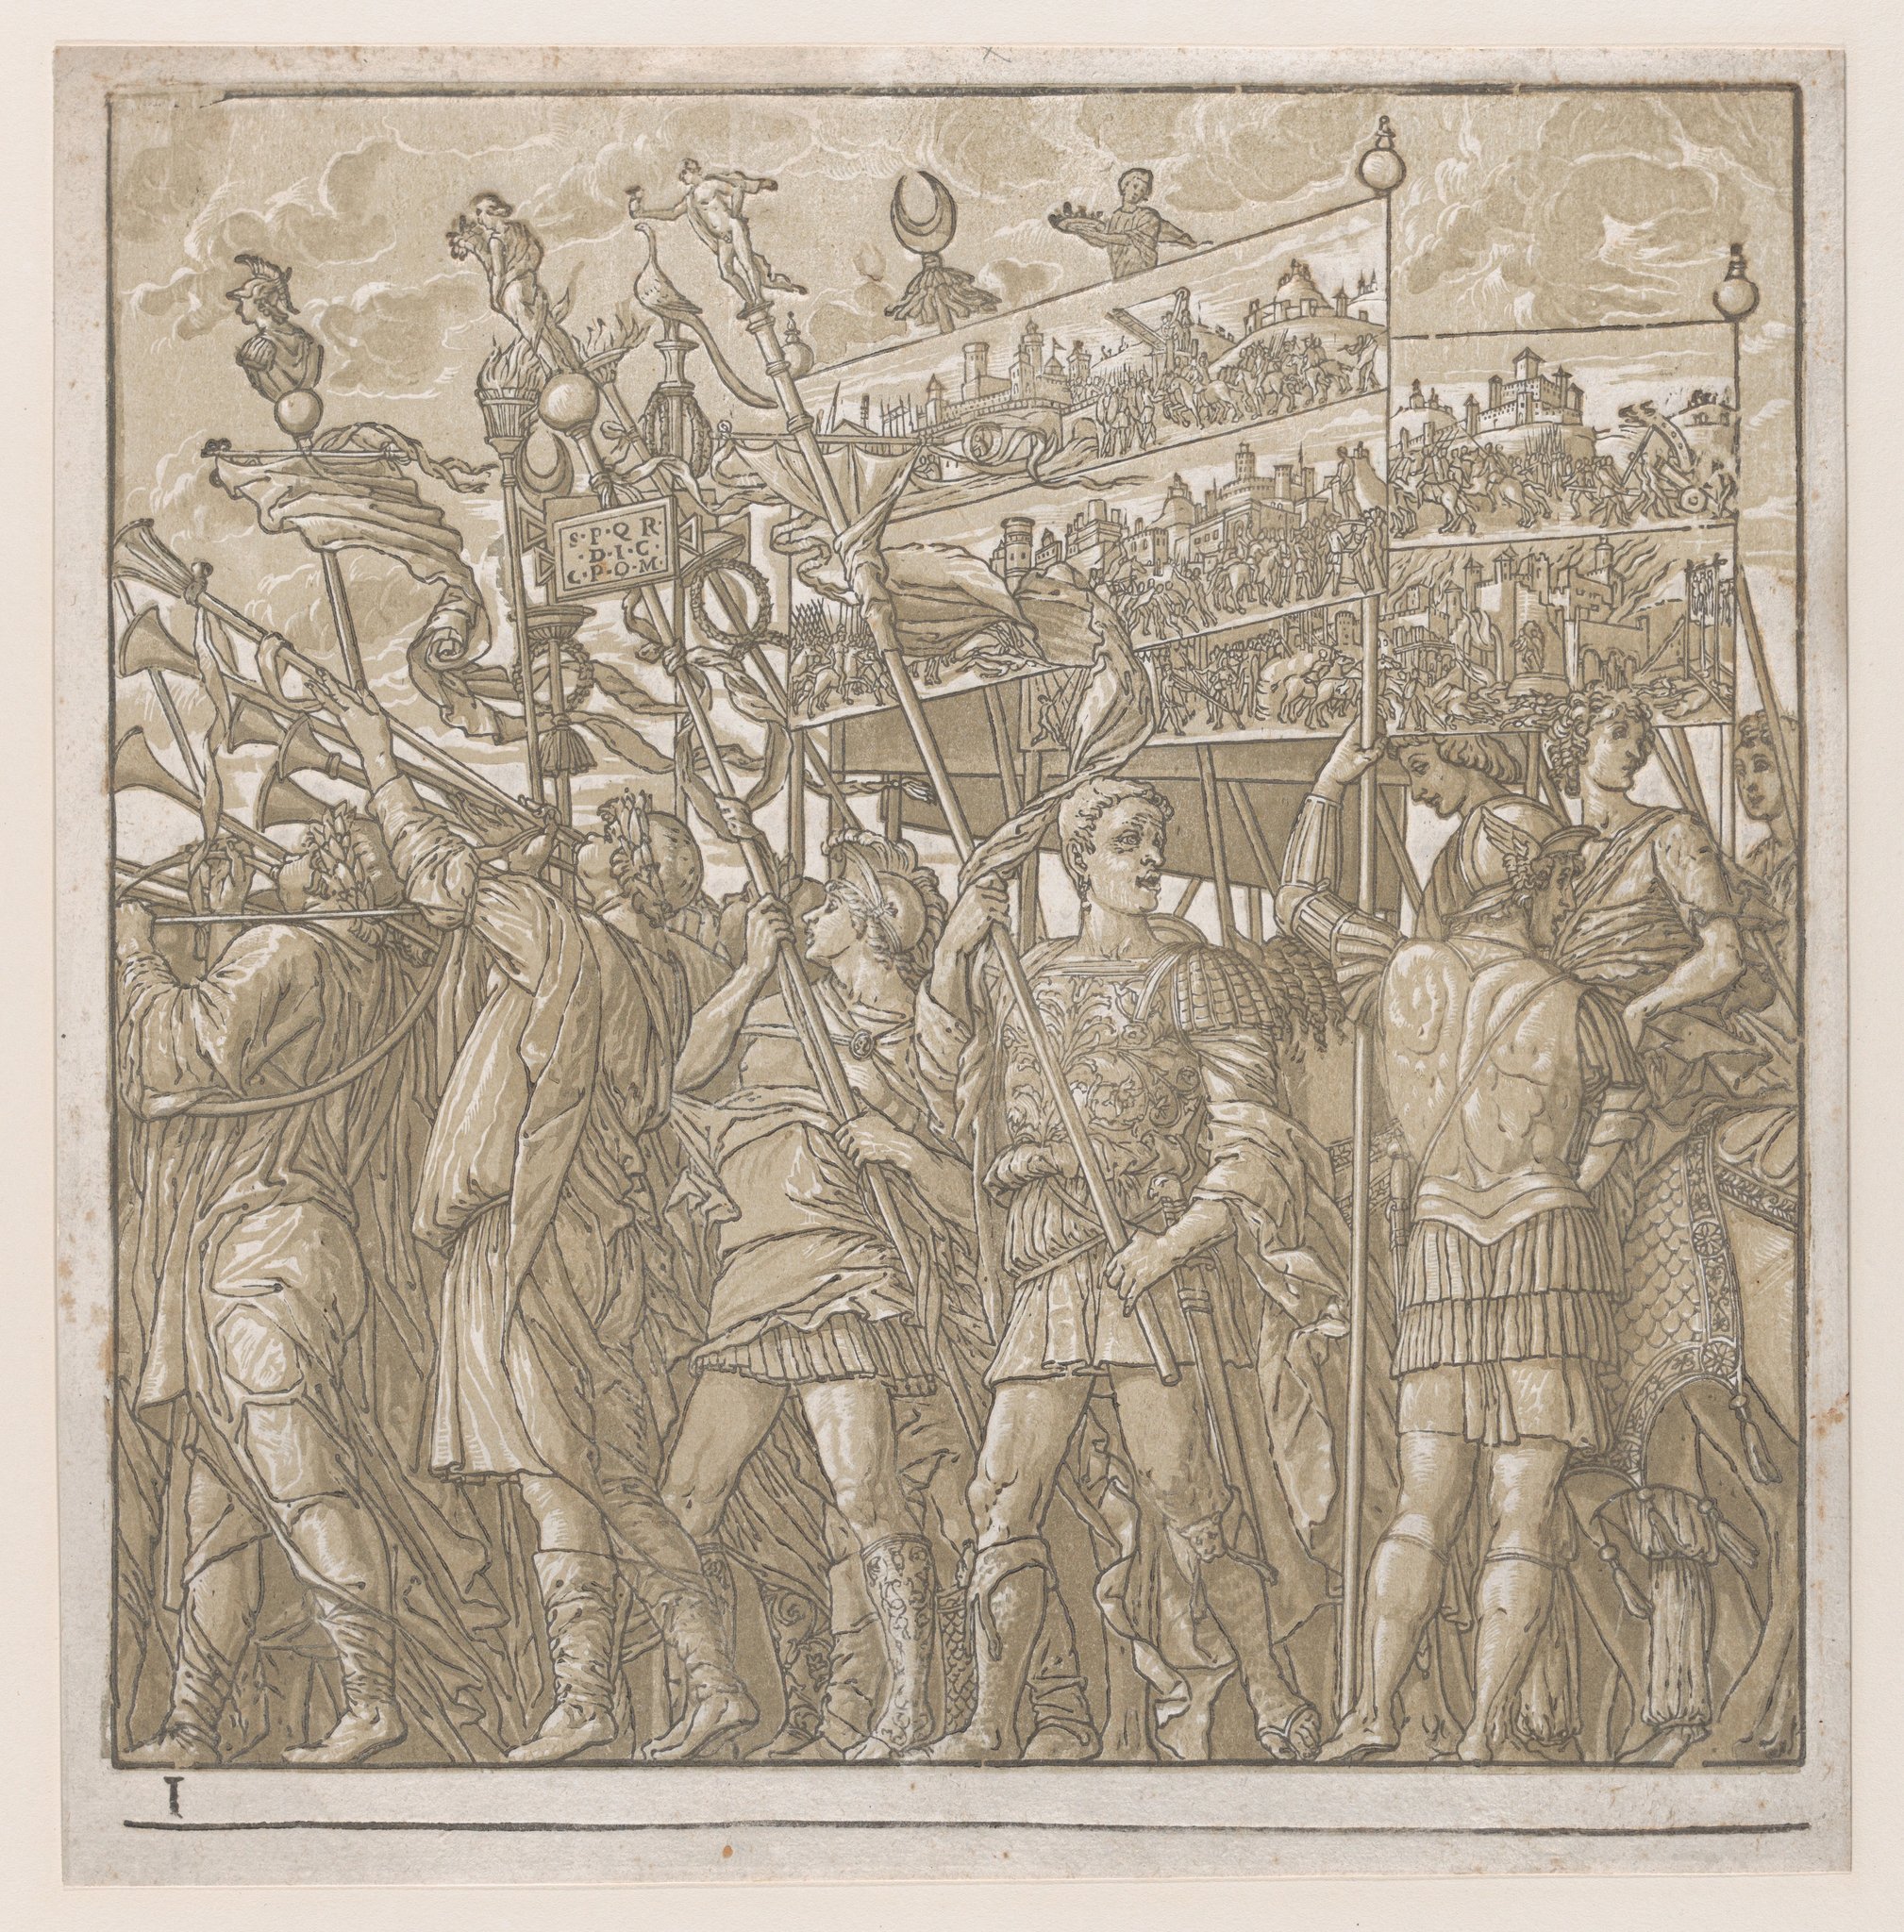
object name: print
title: Sheet 1: Soldiers carrying banners depicting Julius Caesar's triumphant military exploits, from "The Triumph of Julius Caesar"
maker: andrea andreani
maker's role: artist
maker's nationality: italian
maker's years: 1558-1629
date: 1599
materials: ink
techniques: woodcut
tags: musical instruments,soldiers,men,flags